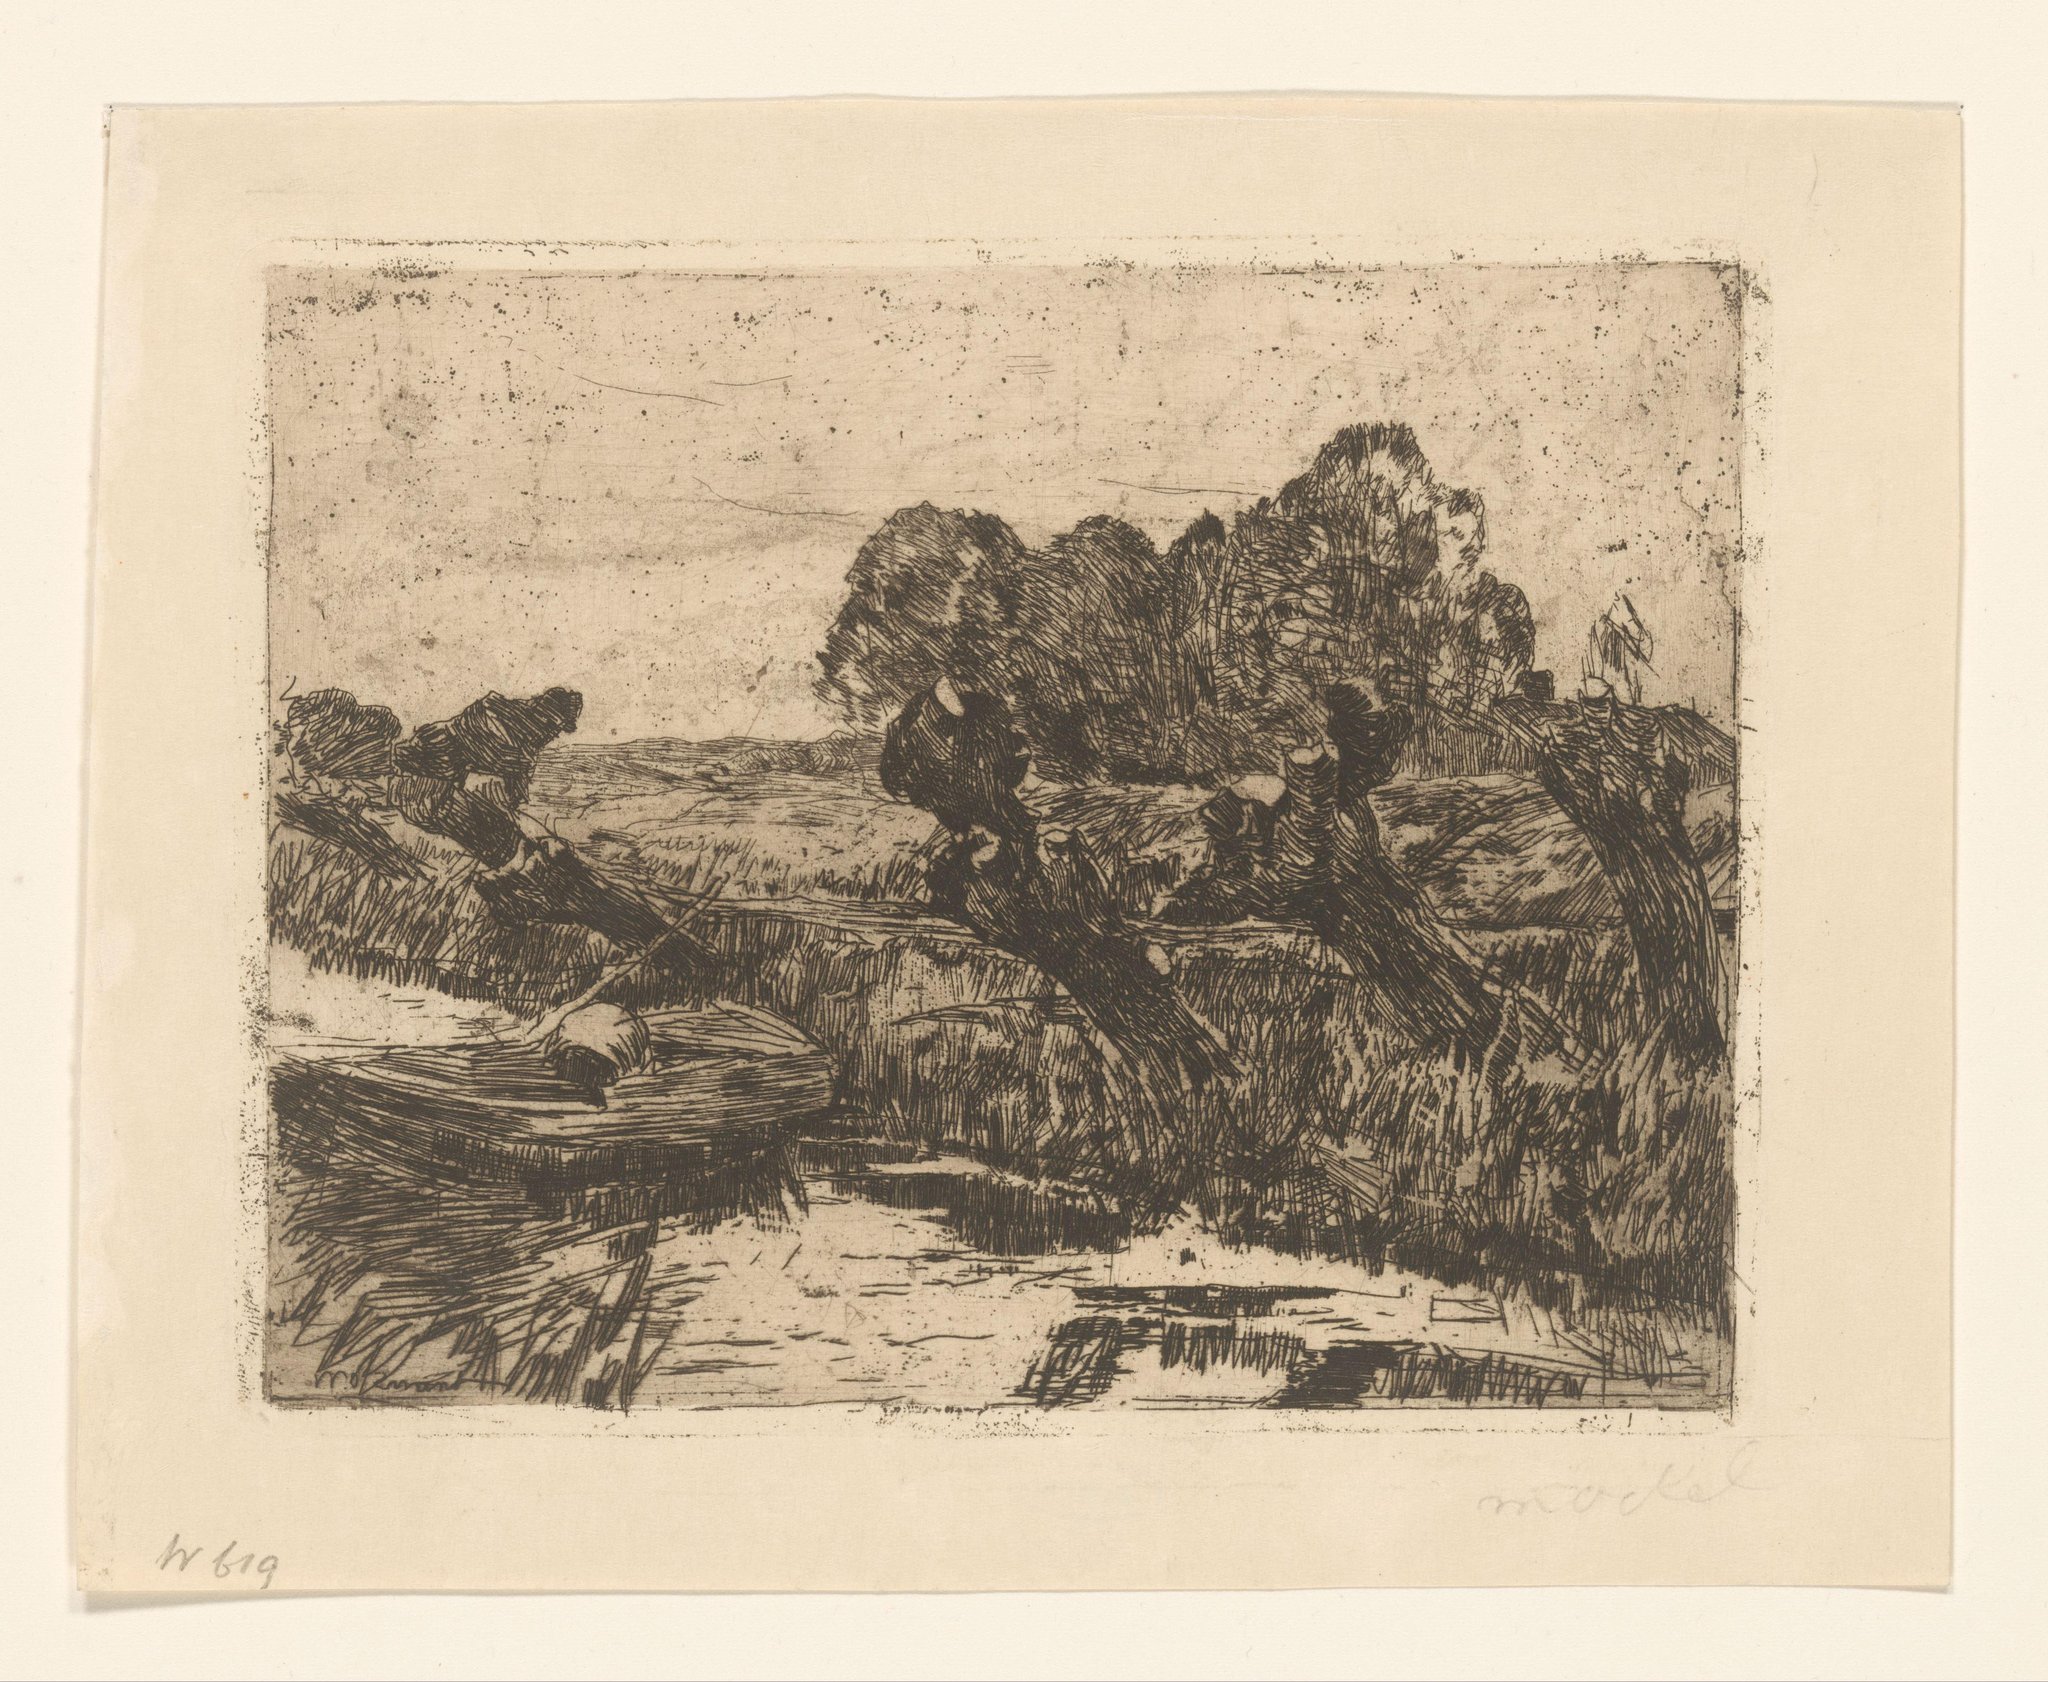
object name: print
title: Wilgen aan een sloot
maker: willem de zwart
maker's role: draughtsman, painter, print maker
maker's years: 1862-1931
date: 1885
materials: paper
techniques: drypoint, etching, intaglio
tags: rowing-boat, canoe, etc., trees: willow, small canal, ditch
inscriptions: collector's mark: Lugt 2228